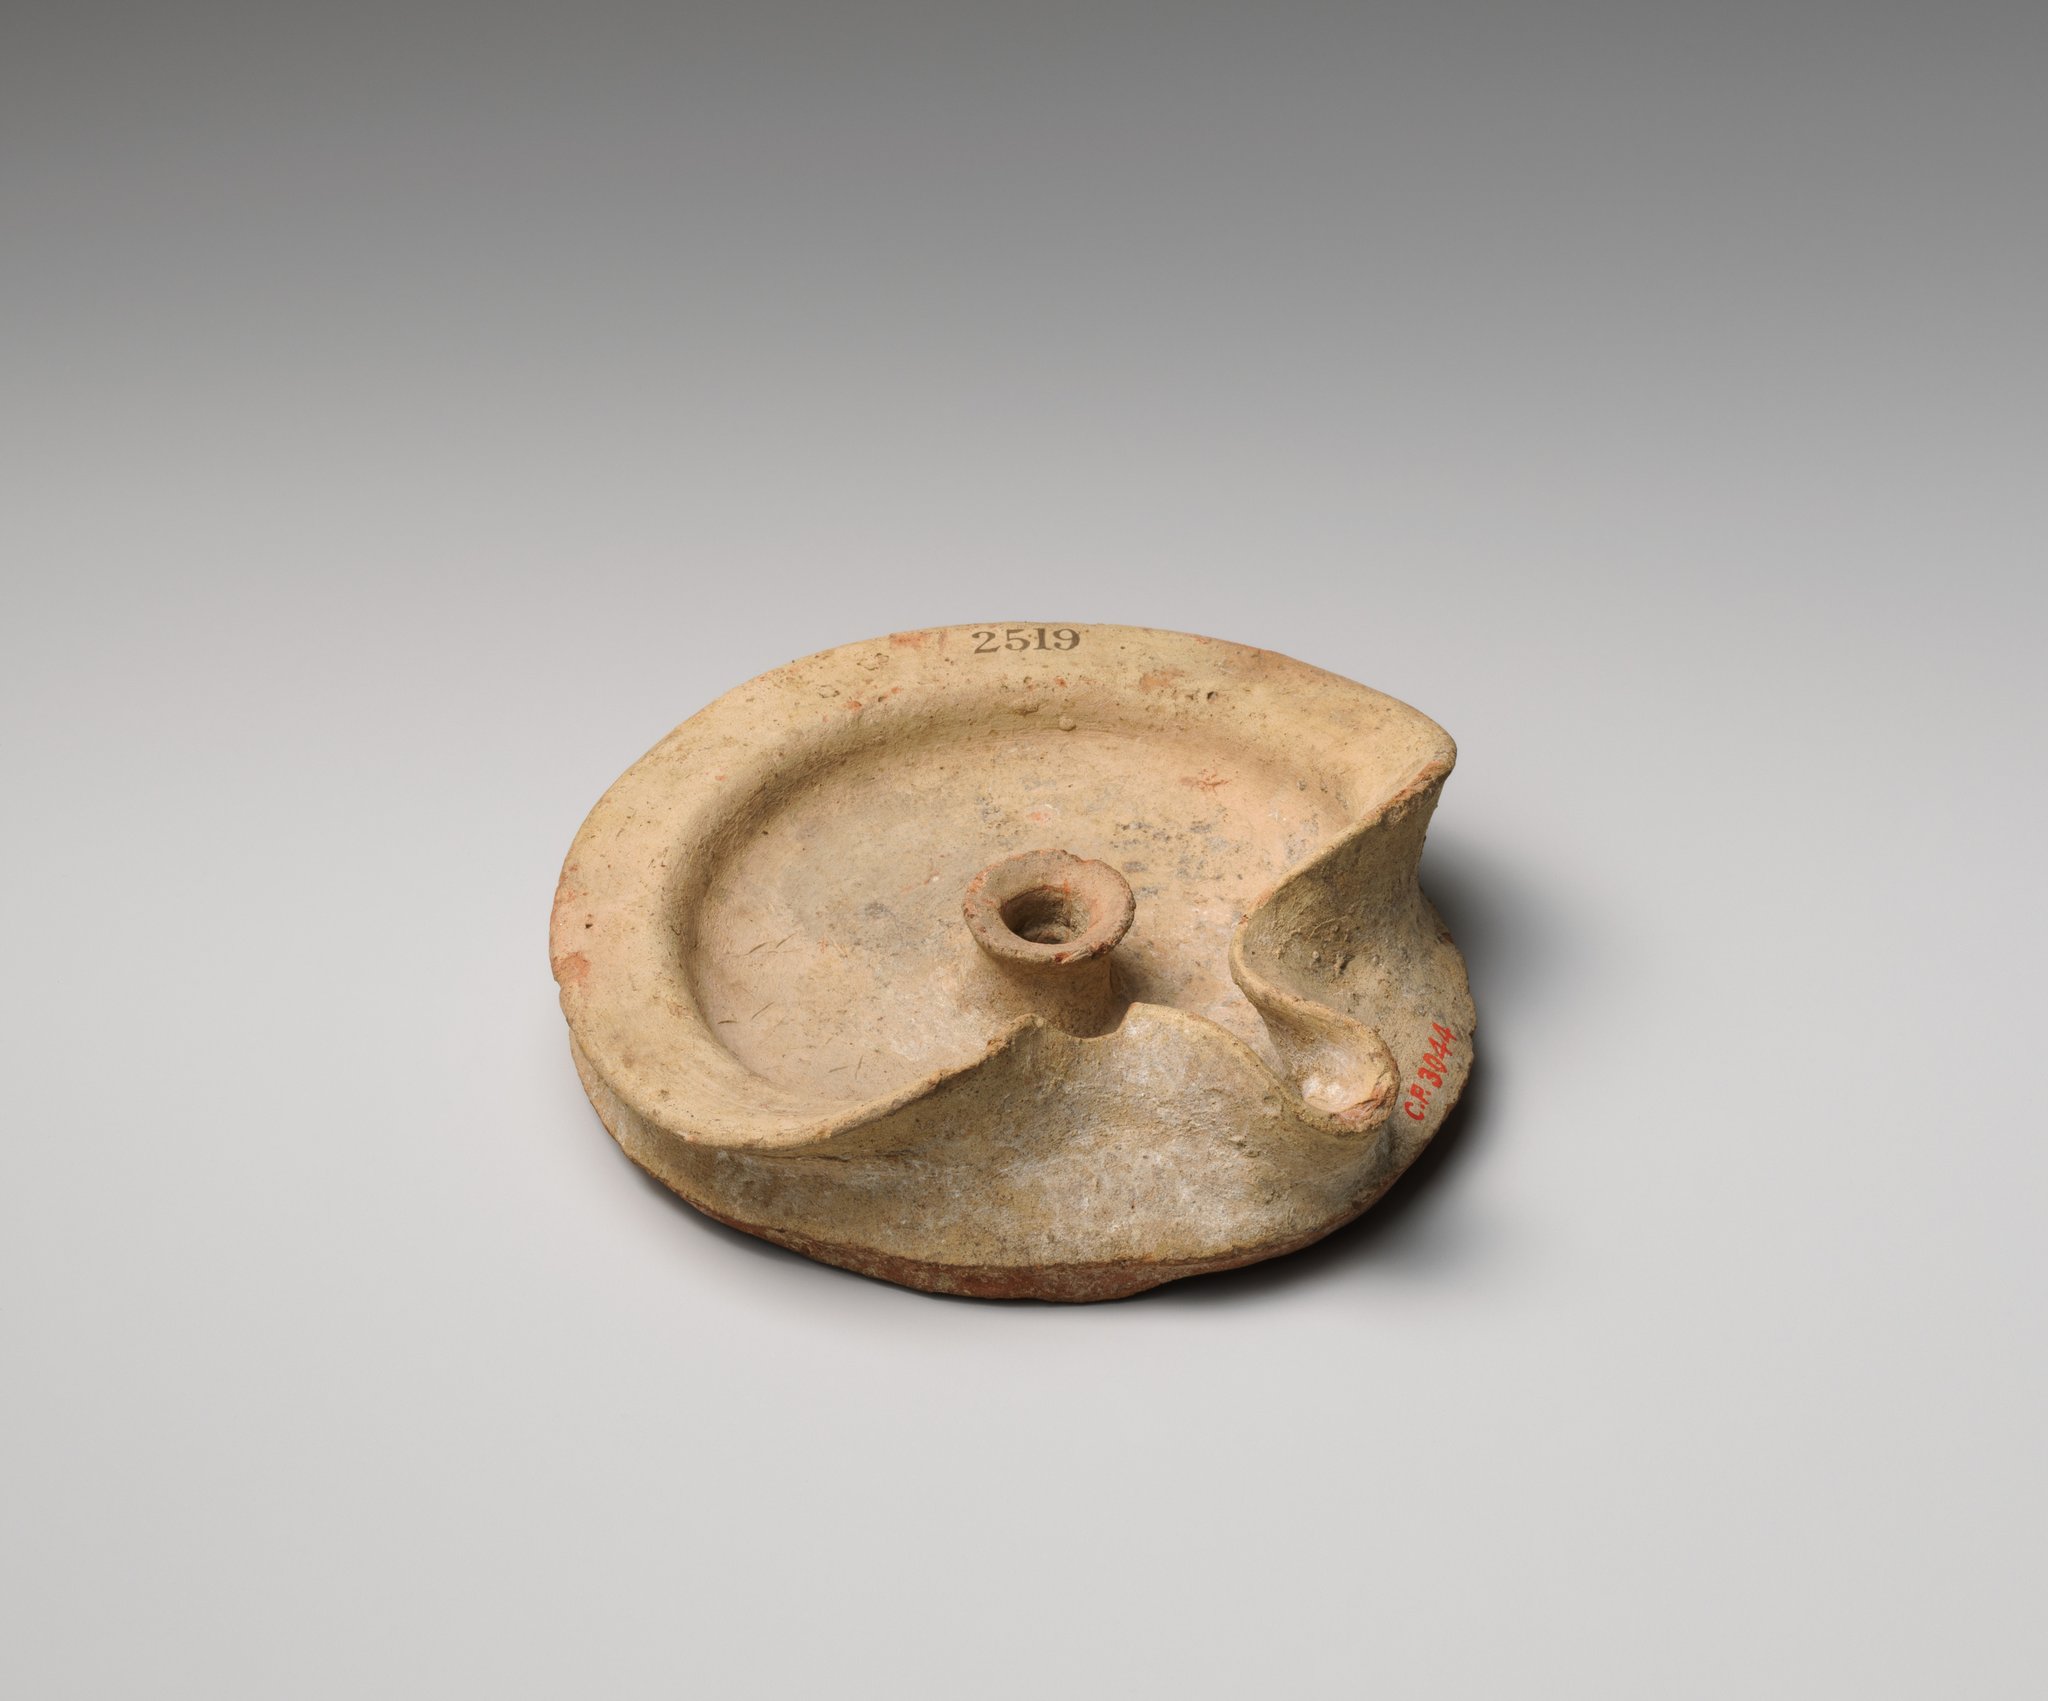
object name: lamp, saucer shaped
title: Terracotta saucer-shaped lamp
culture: cypriot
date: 400-301 BCE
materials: terracotta